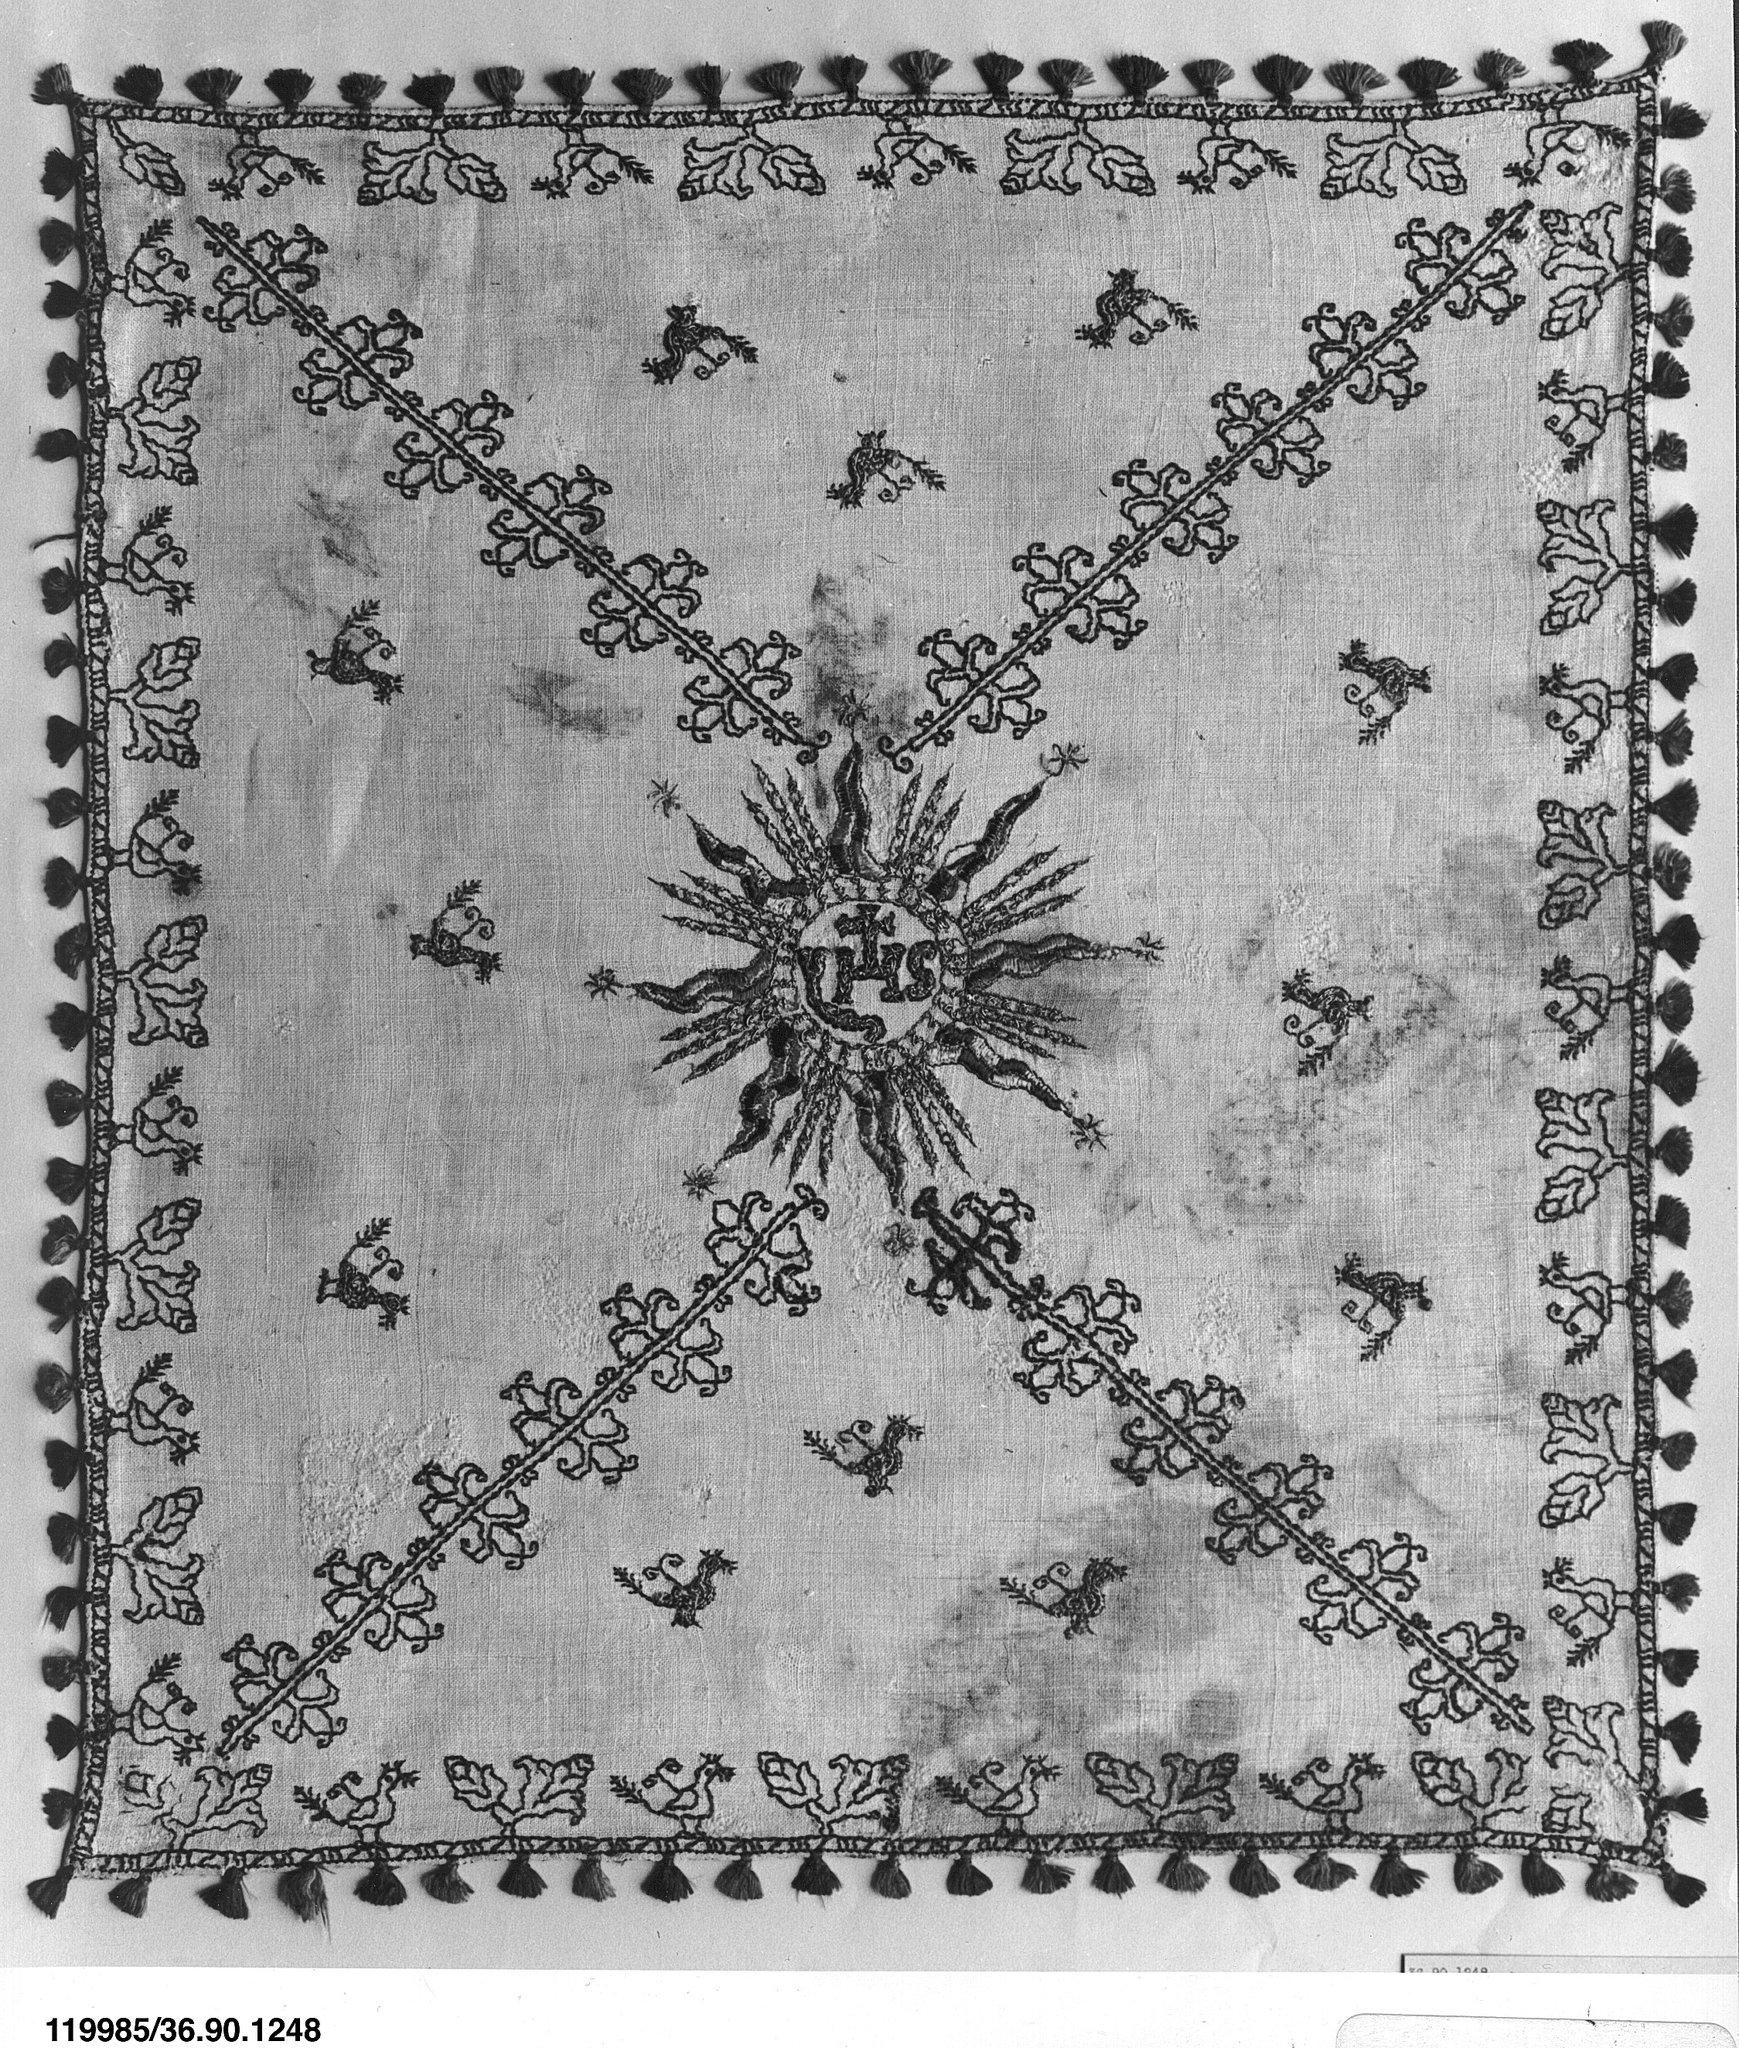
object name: corporal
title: Christogram with a decorative border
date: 1501-1600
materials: linen, metal thread, silk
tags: flowers,insignia